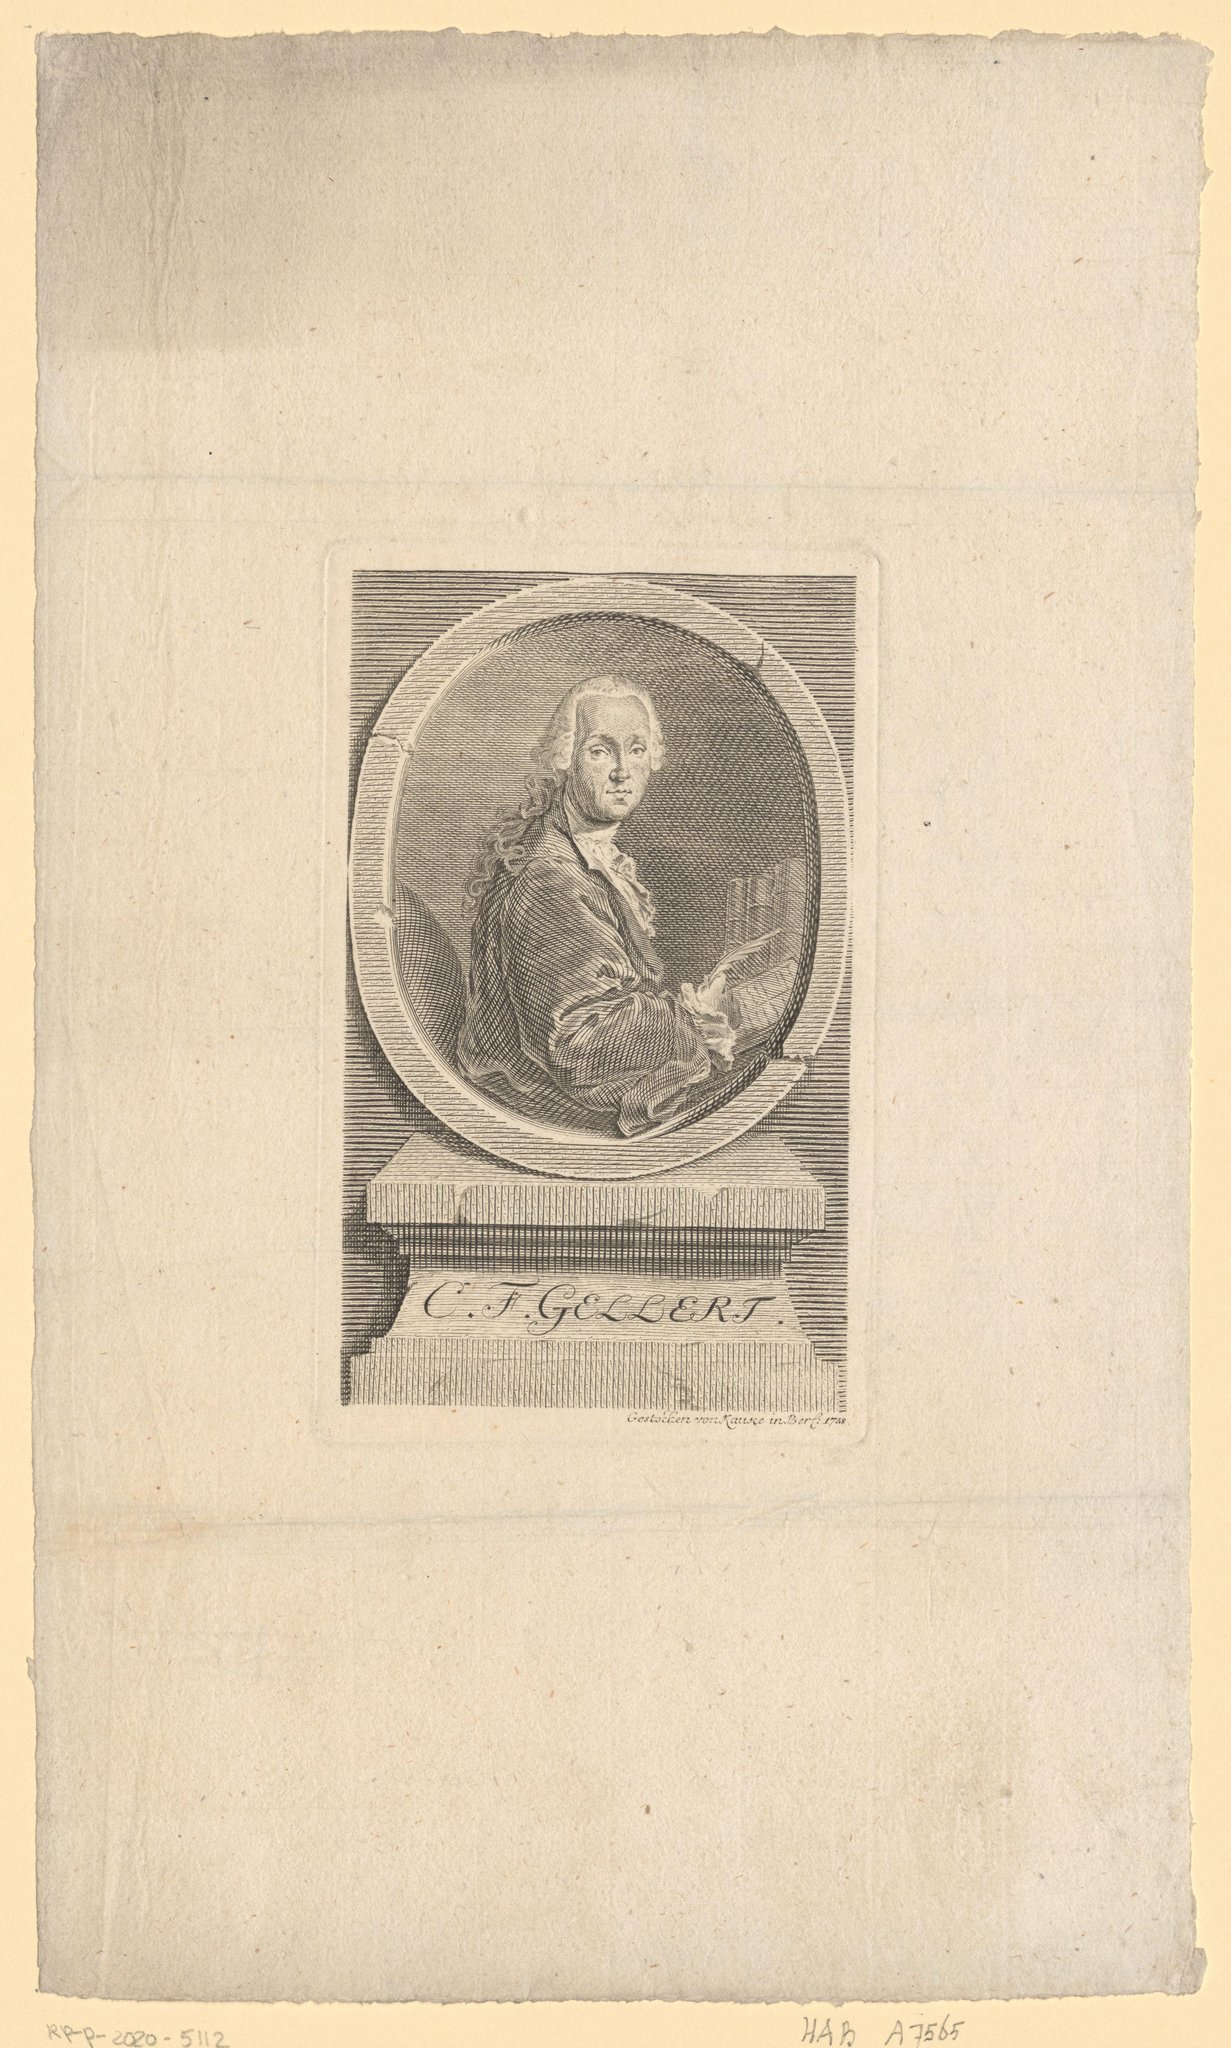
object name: book illustration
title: Portret van Christian Furchtegott Gellert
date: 1758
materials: paper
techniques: etching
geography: leipzig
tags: historical persons, writer, poet, author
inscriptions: date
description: Prent uit: Bibliothek der schönen Wissenschaften und der freyen Künste. 3 dln. Leipzig: Johann Gottfried Dyck, 1758, dl. 1.